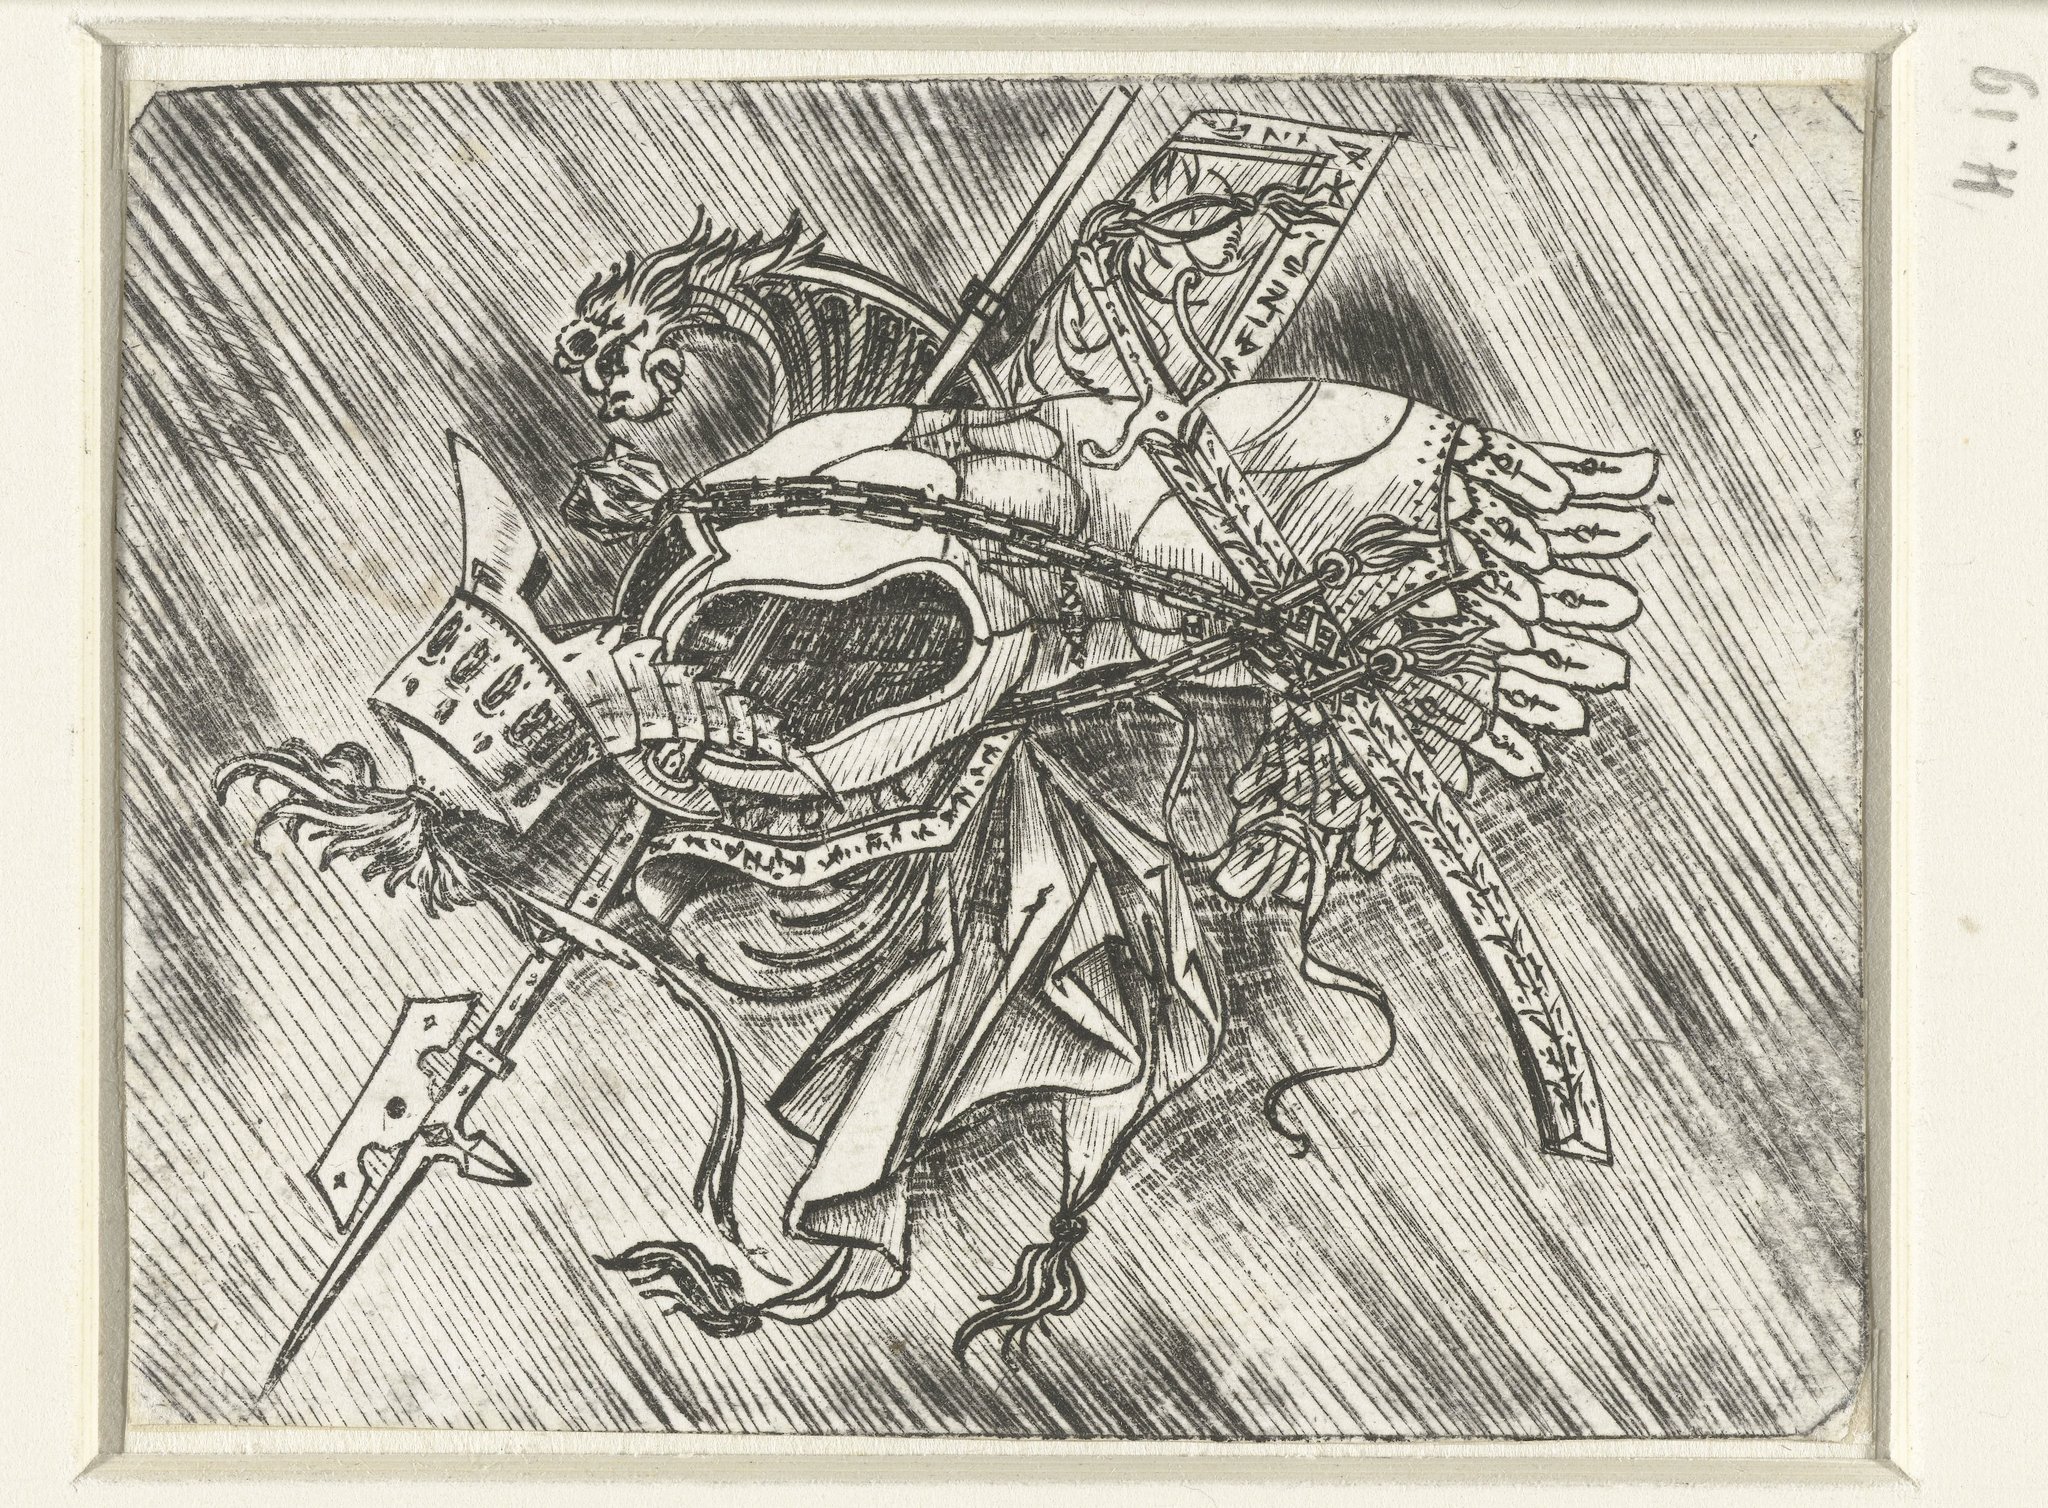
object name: print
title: Wapentrofeeën waaronder harnas en helm en hellebaard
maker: meester van 1515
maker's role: print maker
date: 1500-1548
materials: paper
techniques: drypoint, engraving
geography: italy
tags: trophy ~ battle, war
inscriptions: collector's mark: Lugt 240